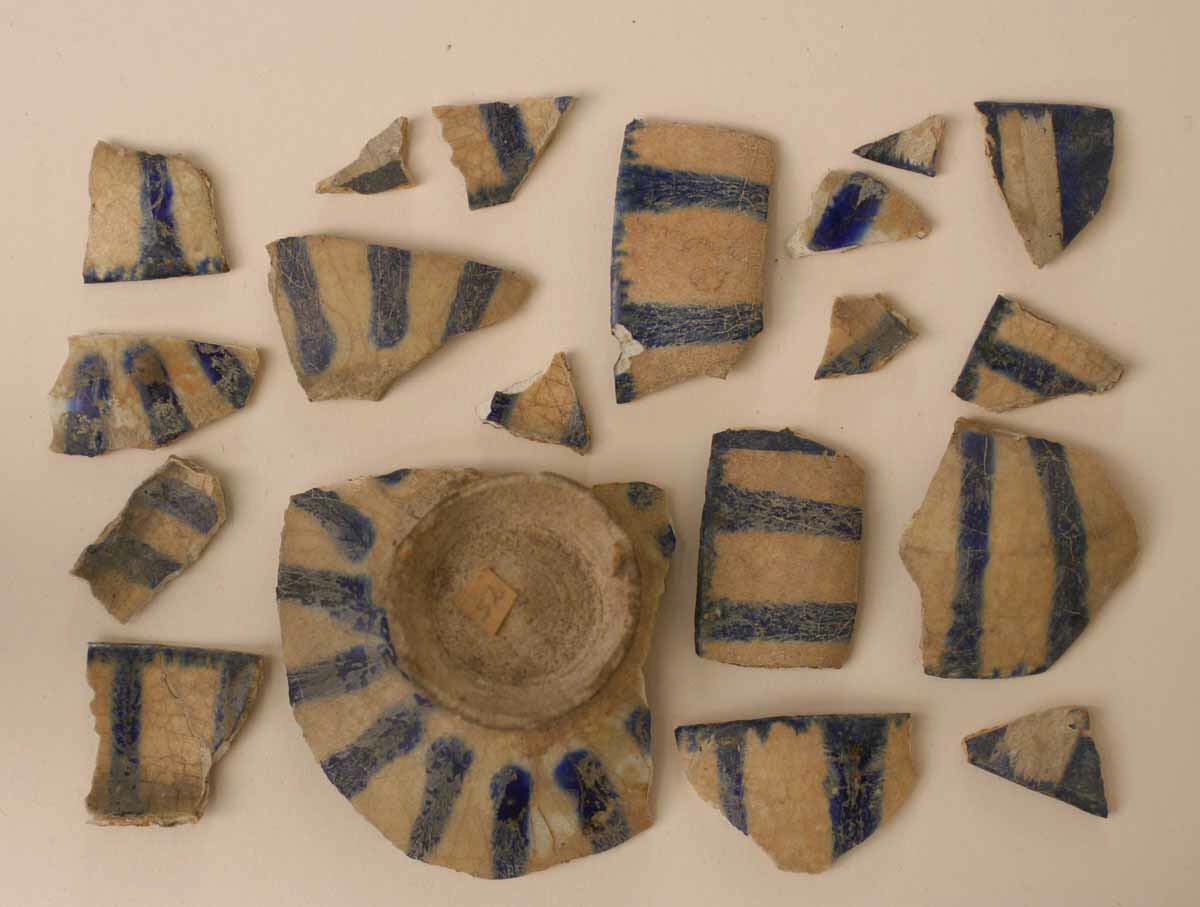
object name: bowl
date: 1201-1300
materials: earthenware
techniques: glazing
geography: iran